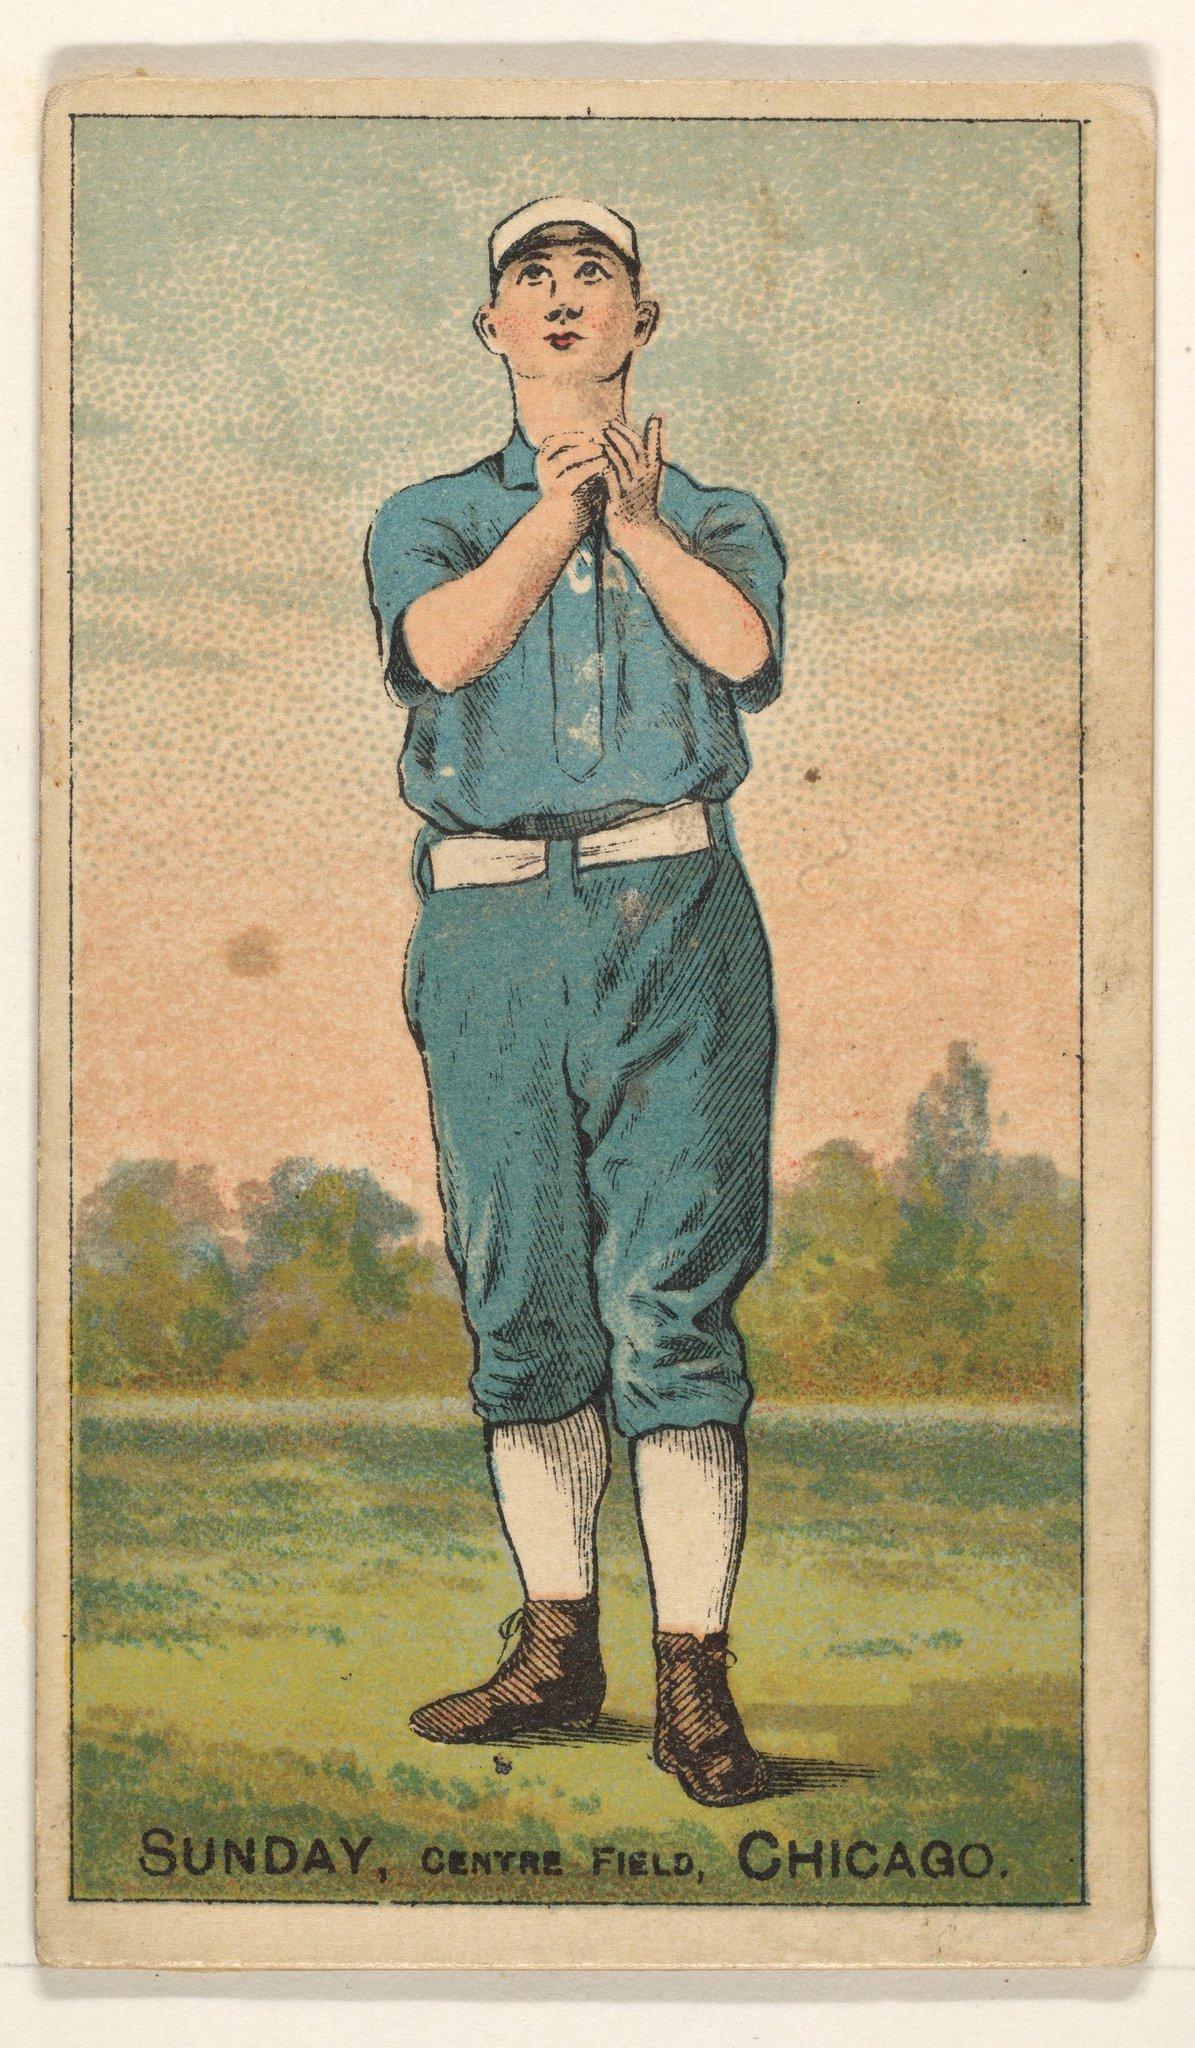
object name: baseball card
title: Sunday, Center Field, Chicago, from the Gold Coin series (N284) for Gold Coin Chewing Tobacco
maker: d. buchner & co., new york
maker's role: publisher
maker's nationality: american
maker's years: 1850-1900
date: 1887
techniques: color lithograph, drawing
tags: men,baseball,athletes